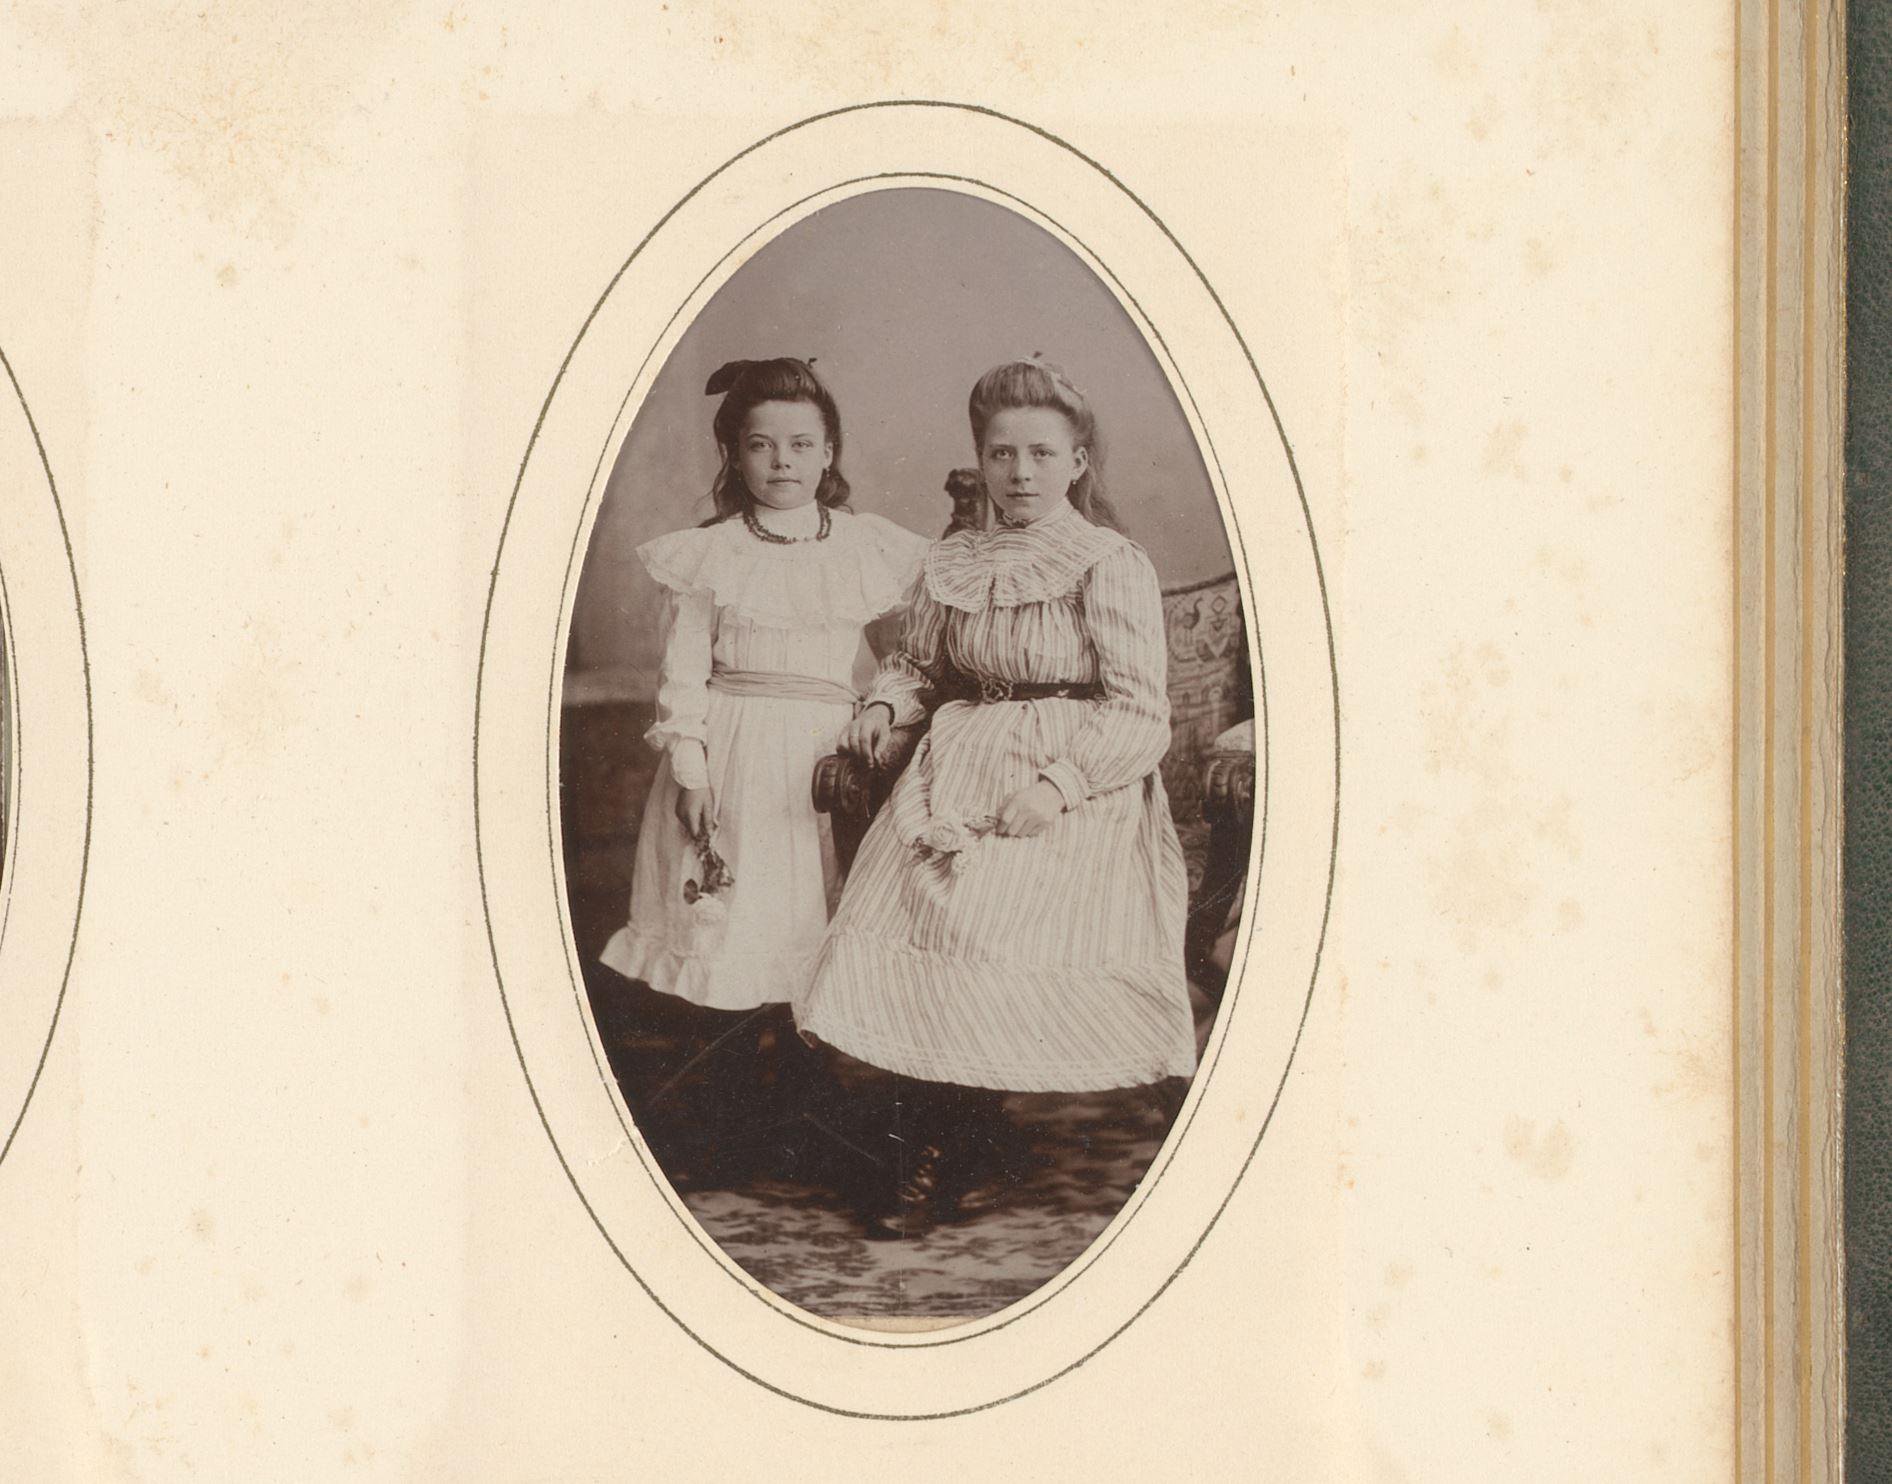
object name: carte de visite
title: Portret van twee meisjes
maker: Anonymous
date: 1880-1920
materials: cardboard, photographic support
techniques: collodion silver print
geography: netherlands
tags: historical persons - bb - woman, girl (child between toddler and youth) (+ two persons)